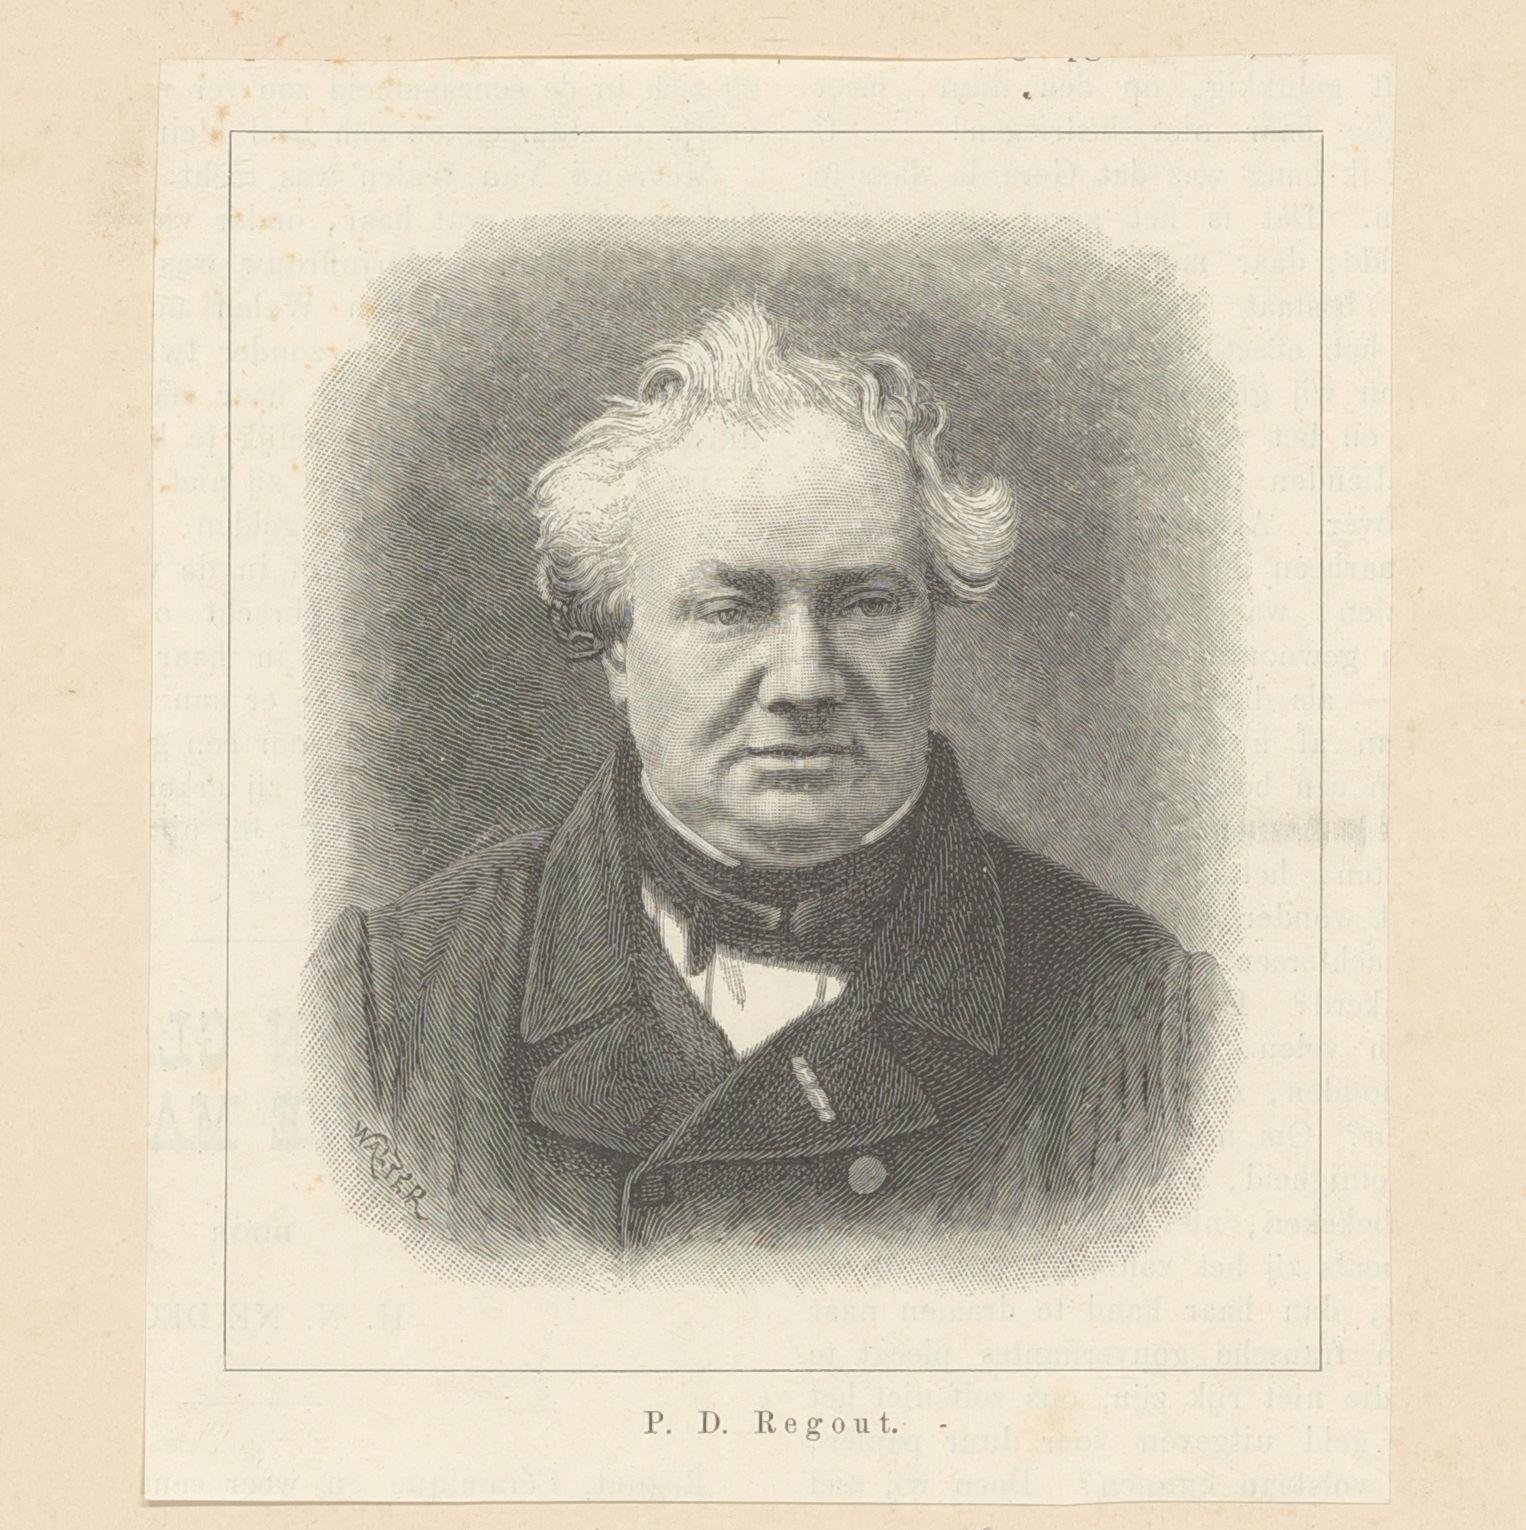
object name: print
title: Portret van Petrus Dominicus Regout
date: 1887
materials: paper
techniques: letterpress printing, engraving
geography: haarlem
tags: politician, historical persons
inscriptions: stamp, stamp, collector's mark: Lugt 1641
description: Onderwerpsrubrieken binnen de Atlas Zeden en Gewoonten: Handel, Nijverheid en verkeer, Beroep en bedrijf, Mannelijk, Glas en Aardewerk.